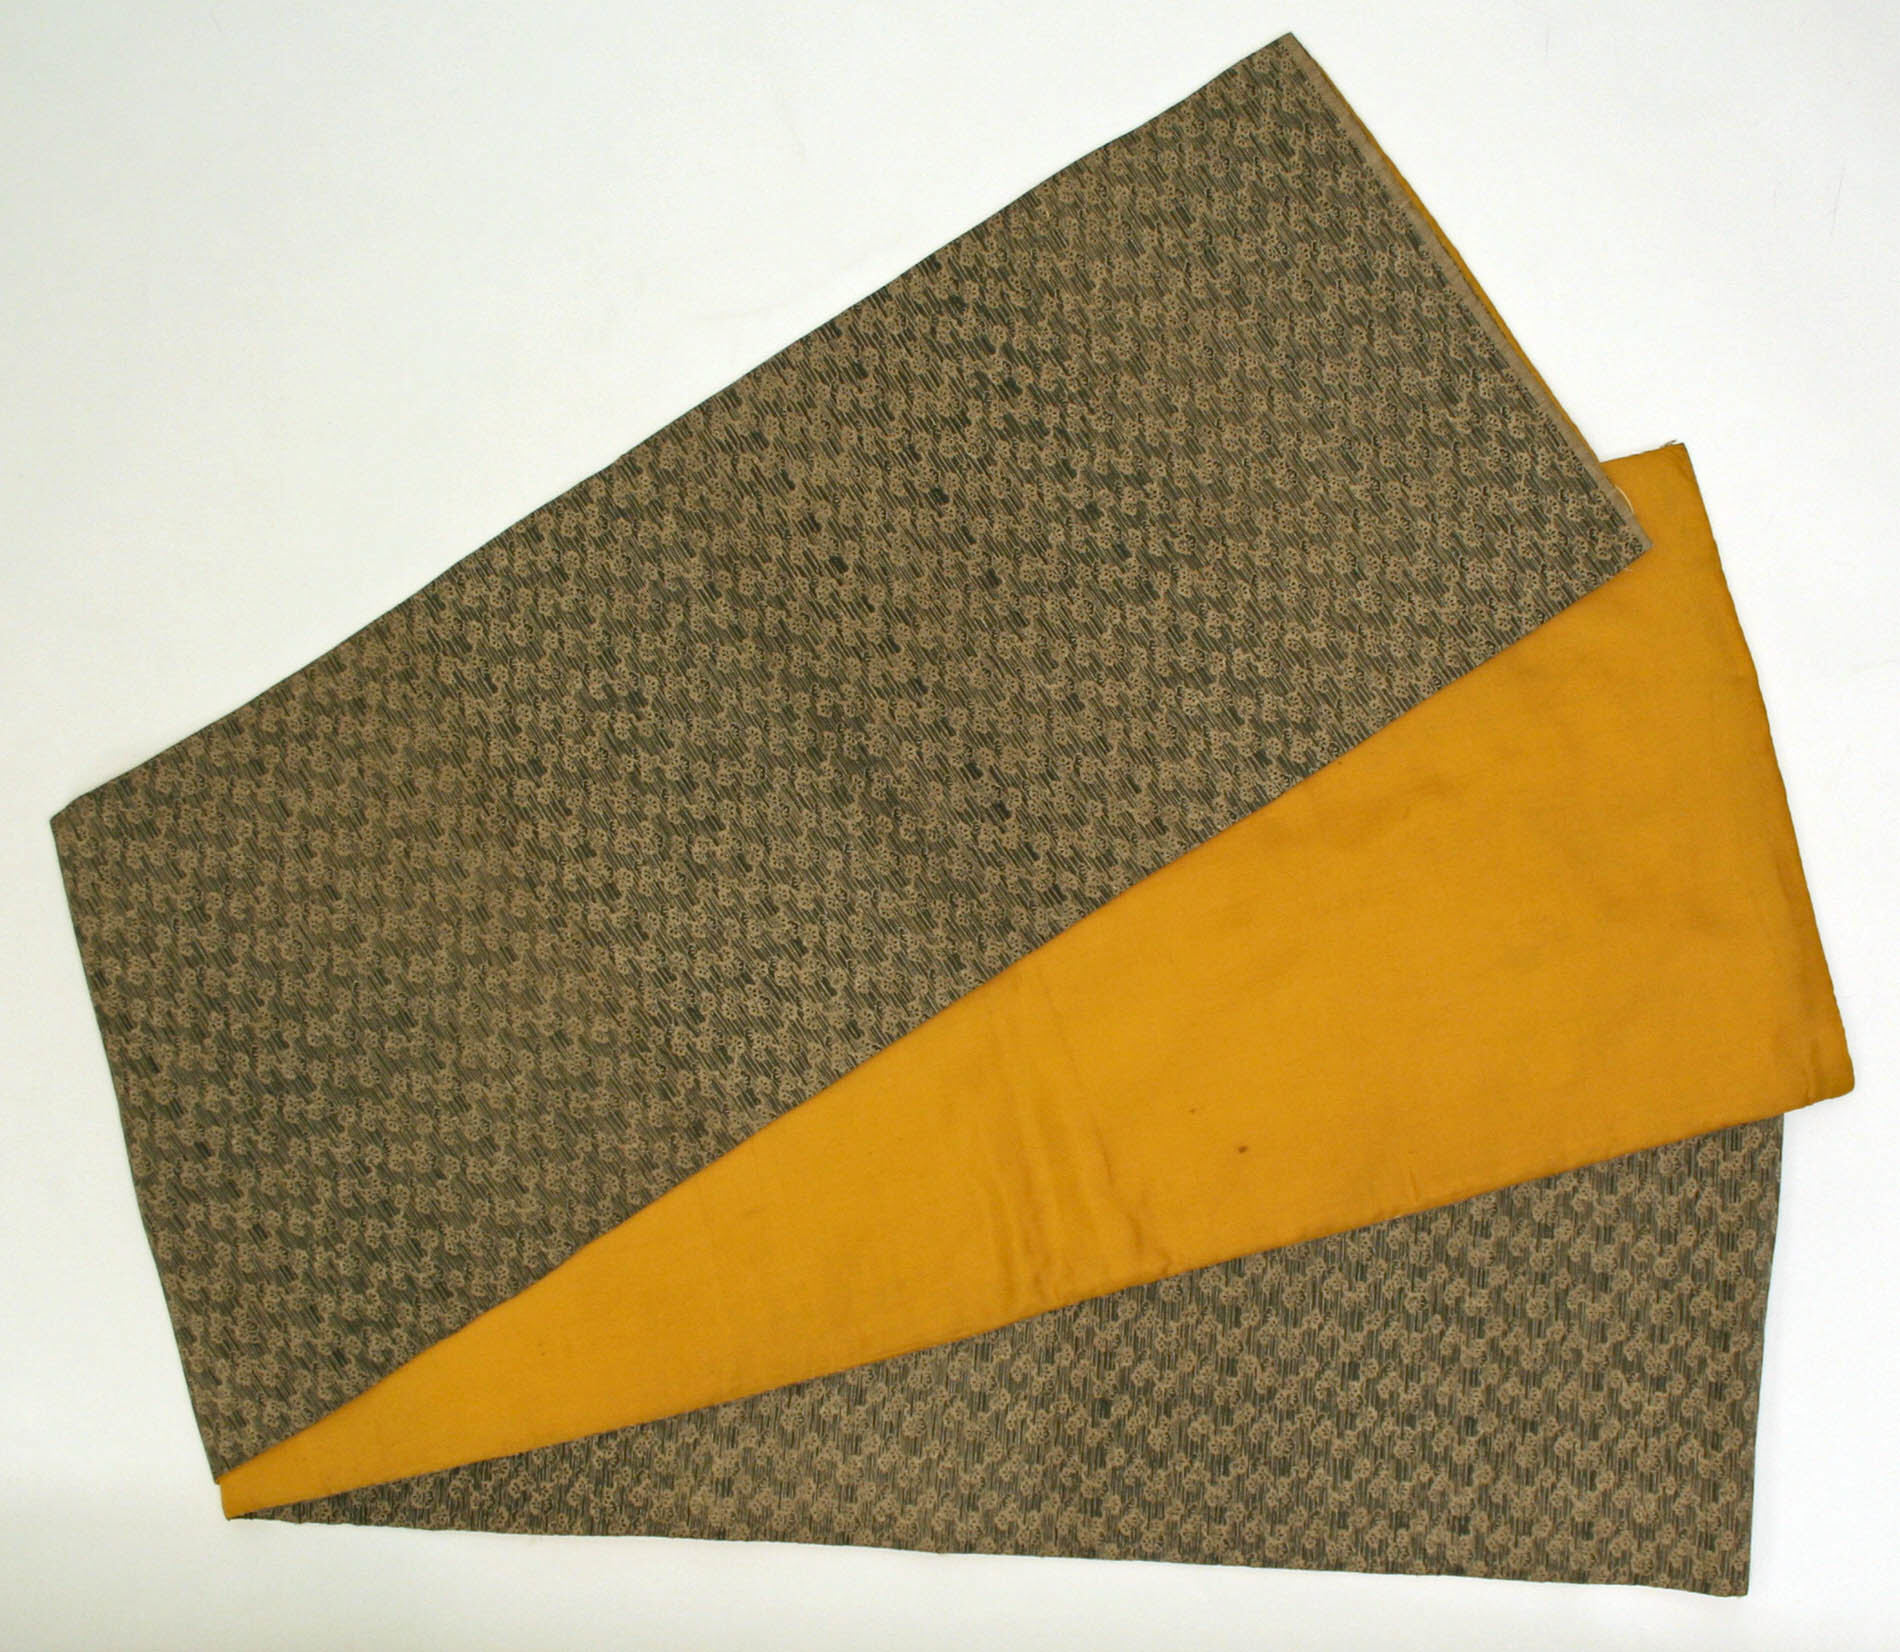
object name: obi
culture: japanese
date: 1867-1900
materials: silk